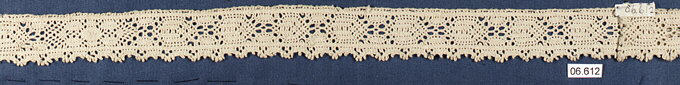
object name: edging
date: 1600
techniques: lace